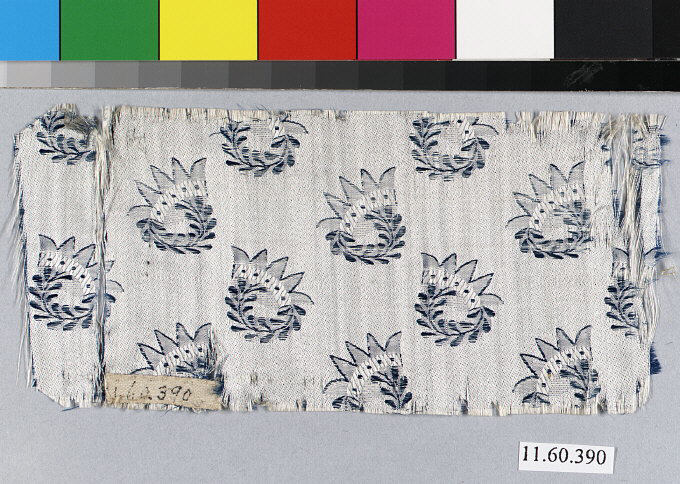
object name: fragment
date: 1801-1900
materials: silk